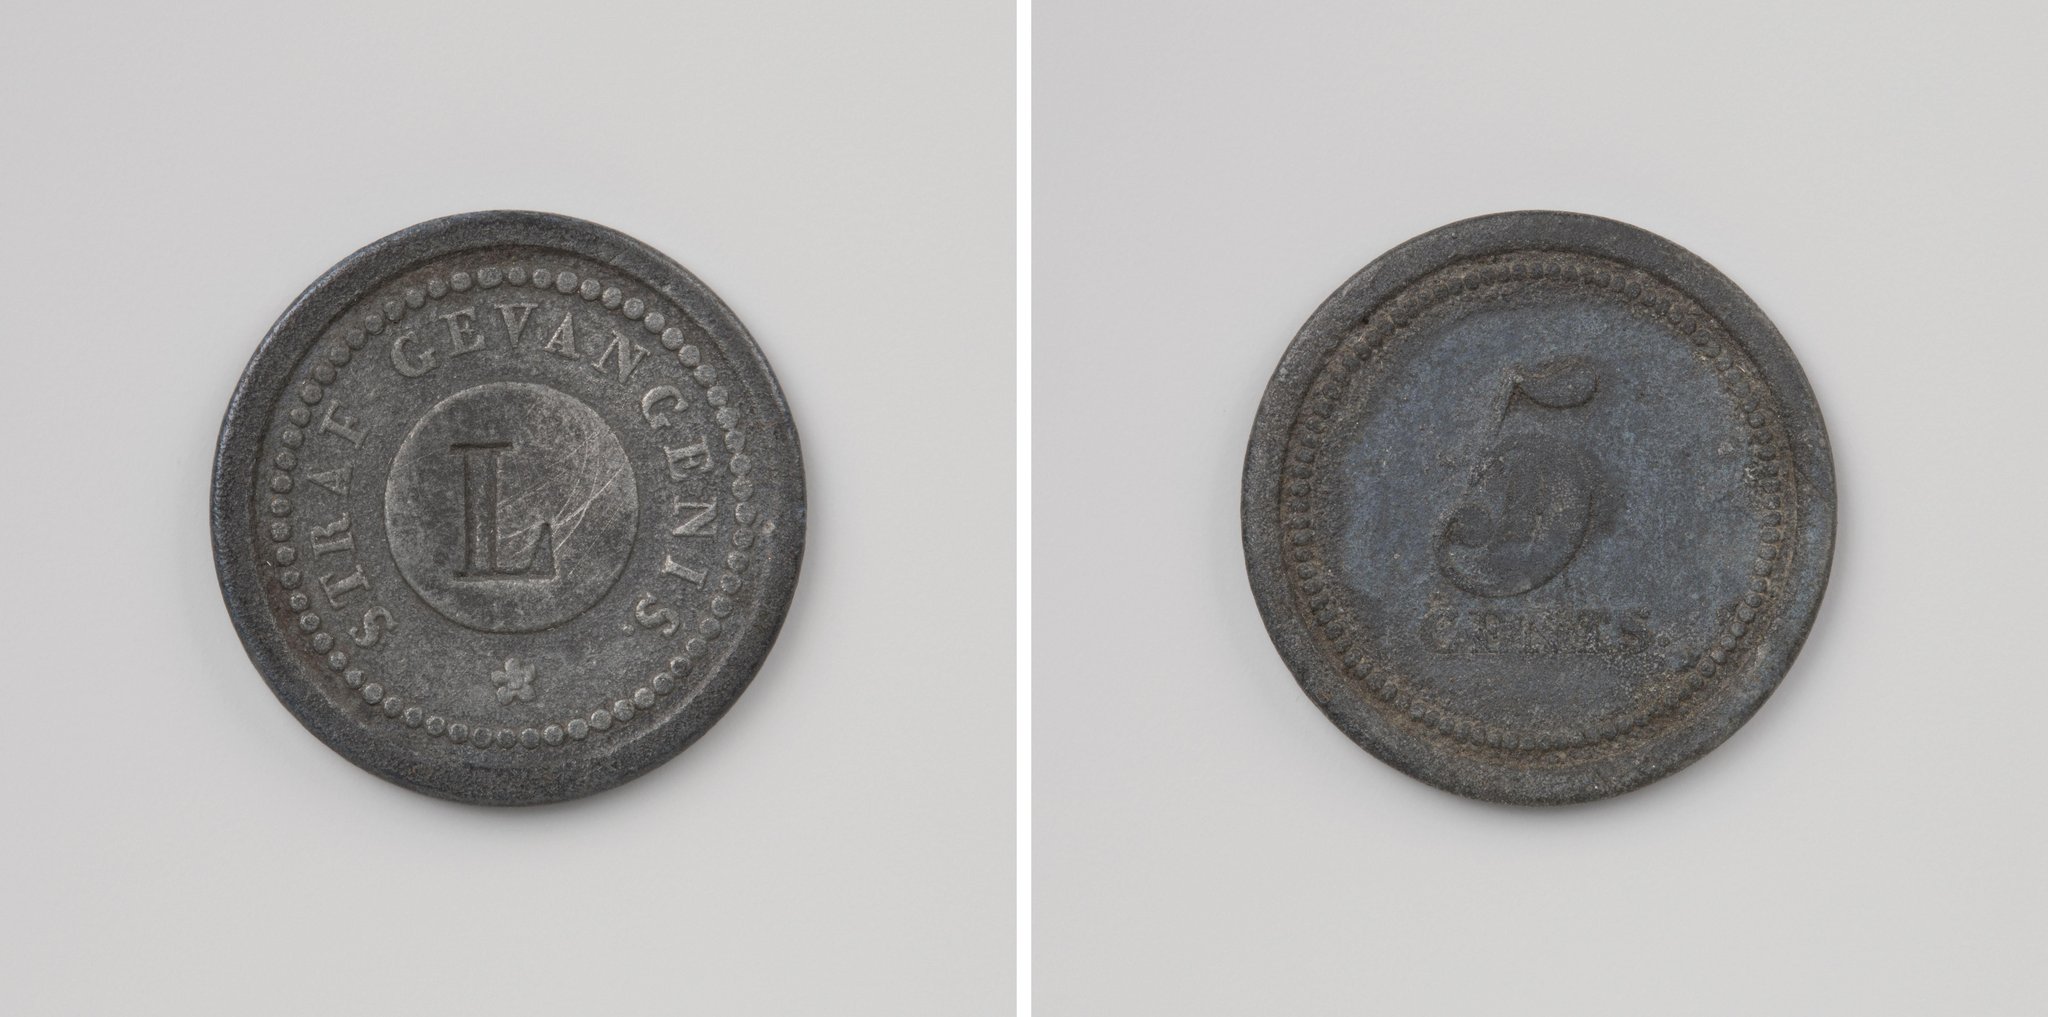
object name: monetary token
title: Militaire strafgevangenis te Leiden, huismunt ter waarde van vijf cents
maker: Anonymous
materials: zinc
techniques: striking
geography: utrecht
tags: leiden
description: Zinken betaalpenning. Voorzijde: letter L binnen omschrift. Keerzijde: waardeaanduiding.